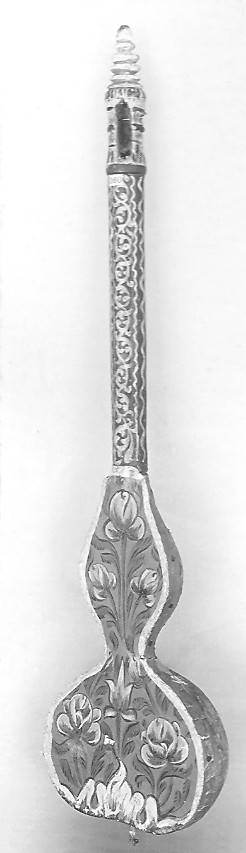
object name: guenbri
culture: saudi arabian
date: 1867-1900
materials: parchment, wood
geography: saudi arabia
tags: flowers